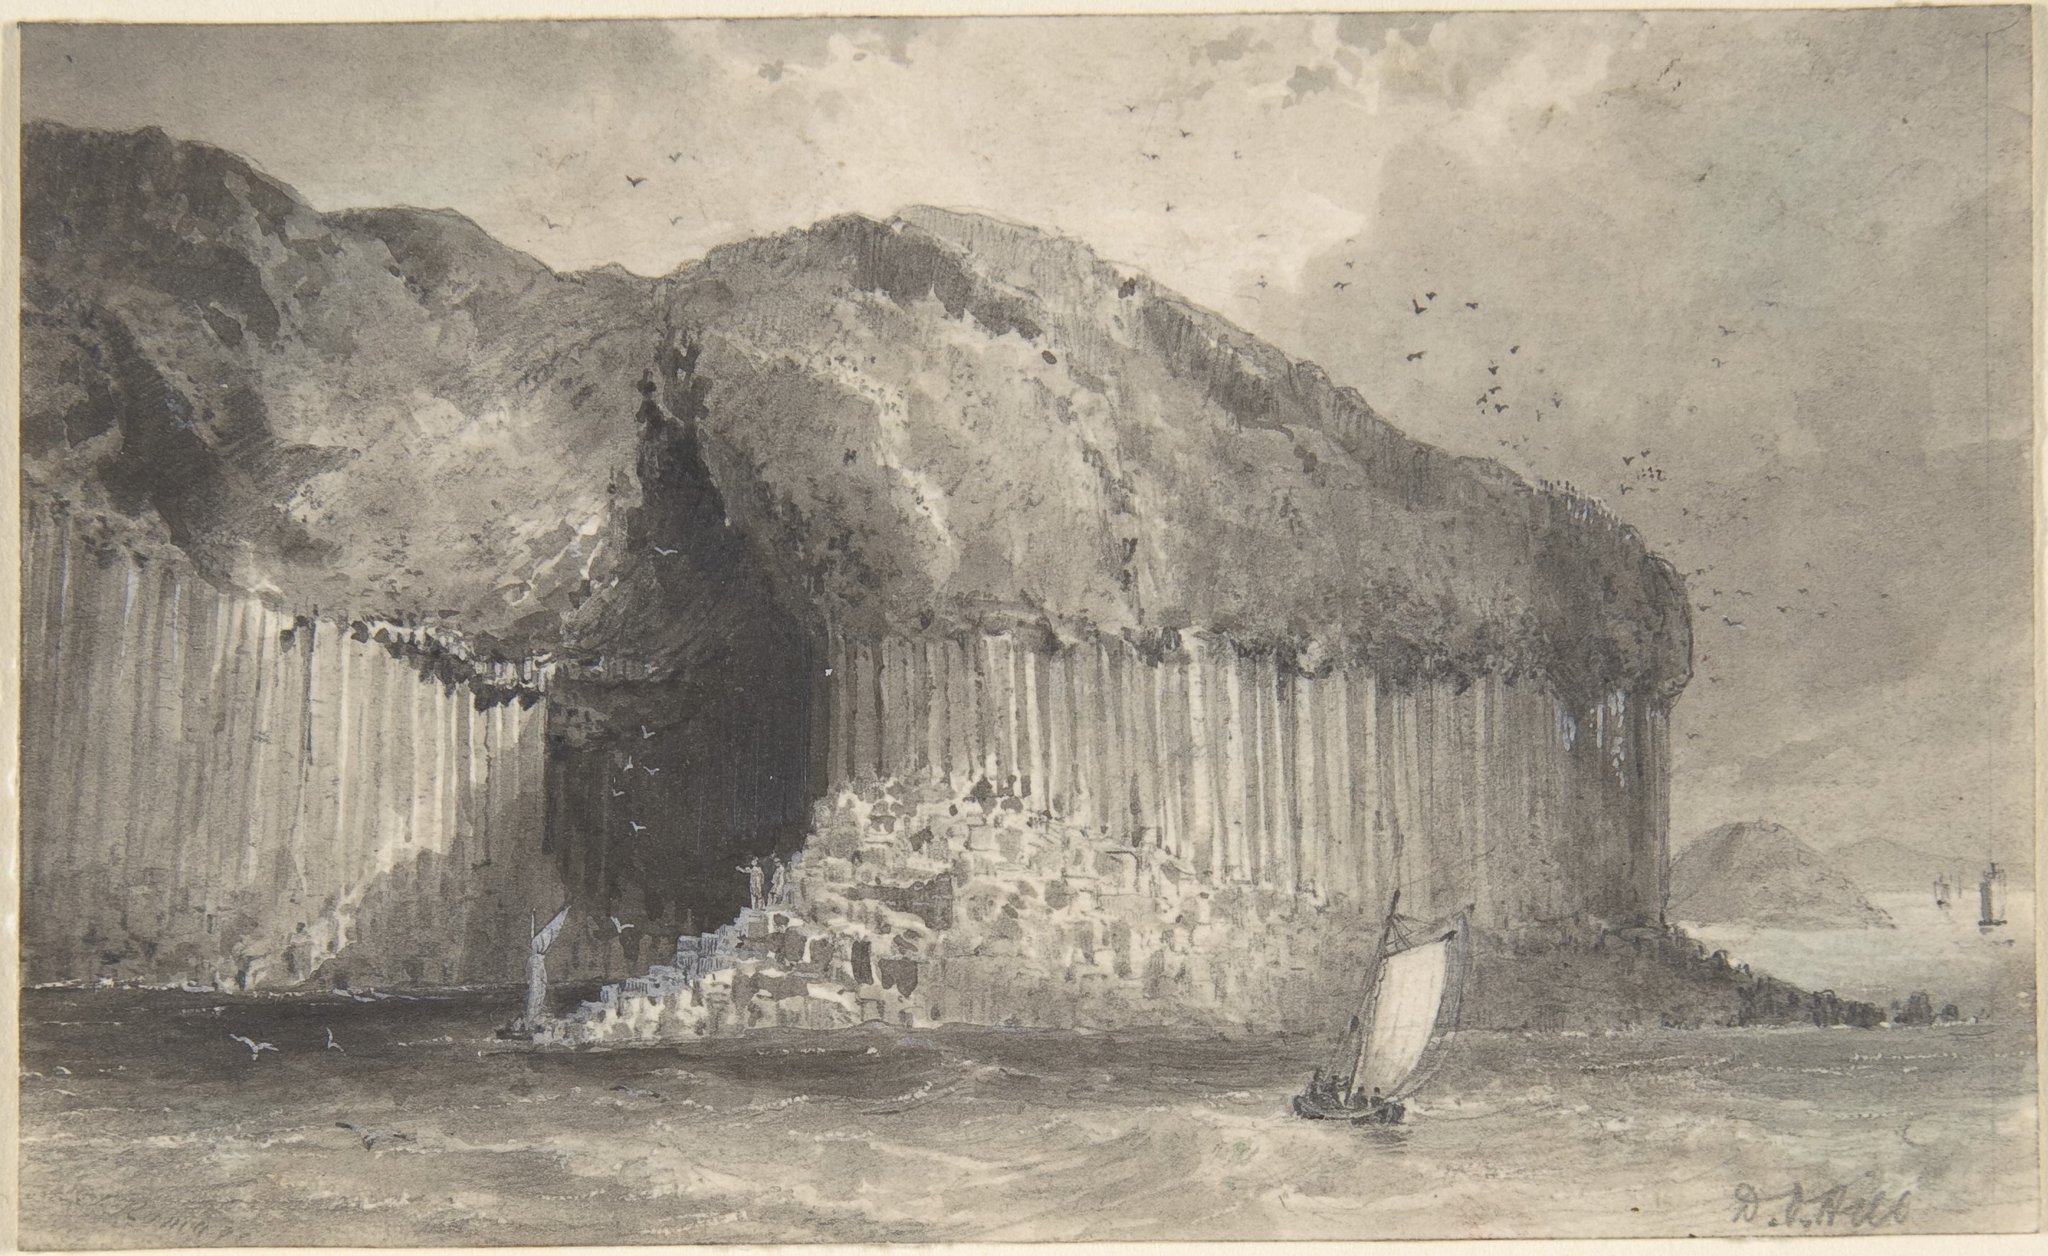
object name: drawing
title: View of Fingal's Cave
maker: david octavius hill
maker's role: artist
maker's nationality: scottish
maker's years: 1802-1870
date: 1820-1870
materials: graphite, ink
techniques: brush, pen, wash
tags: caves